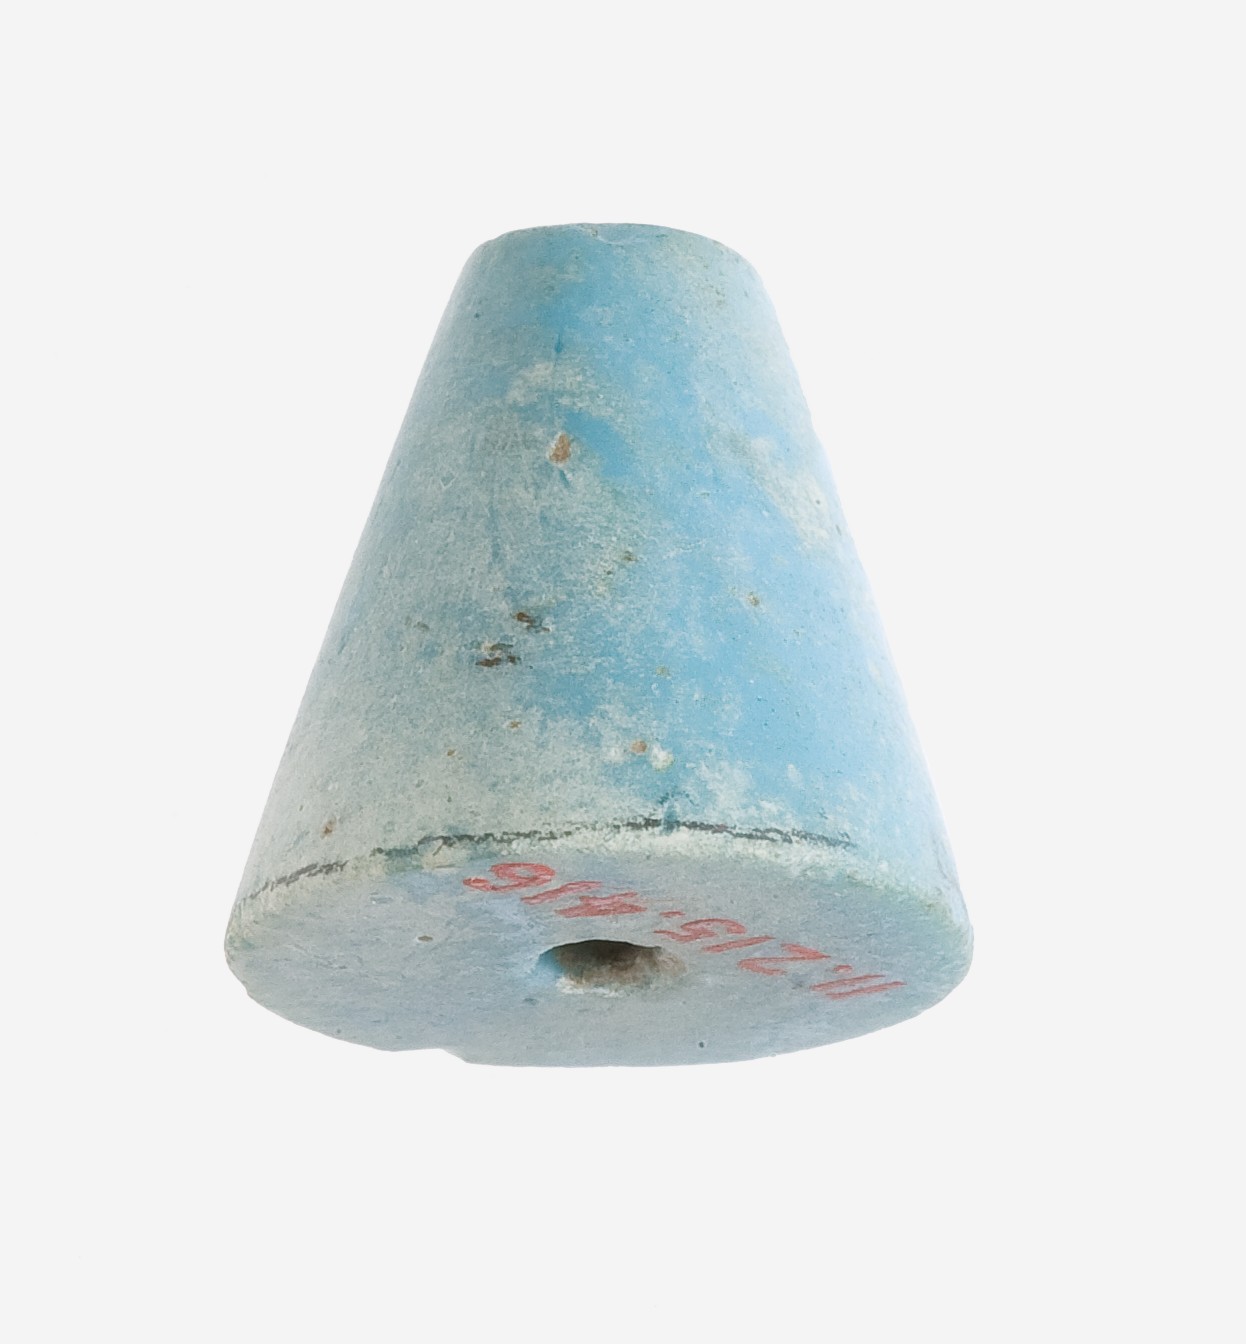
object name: pendant, umbel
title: Umbel Pendant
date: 1390-1352 BCE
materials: faience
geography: egypt